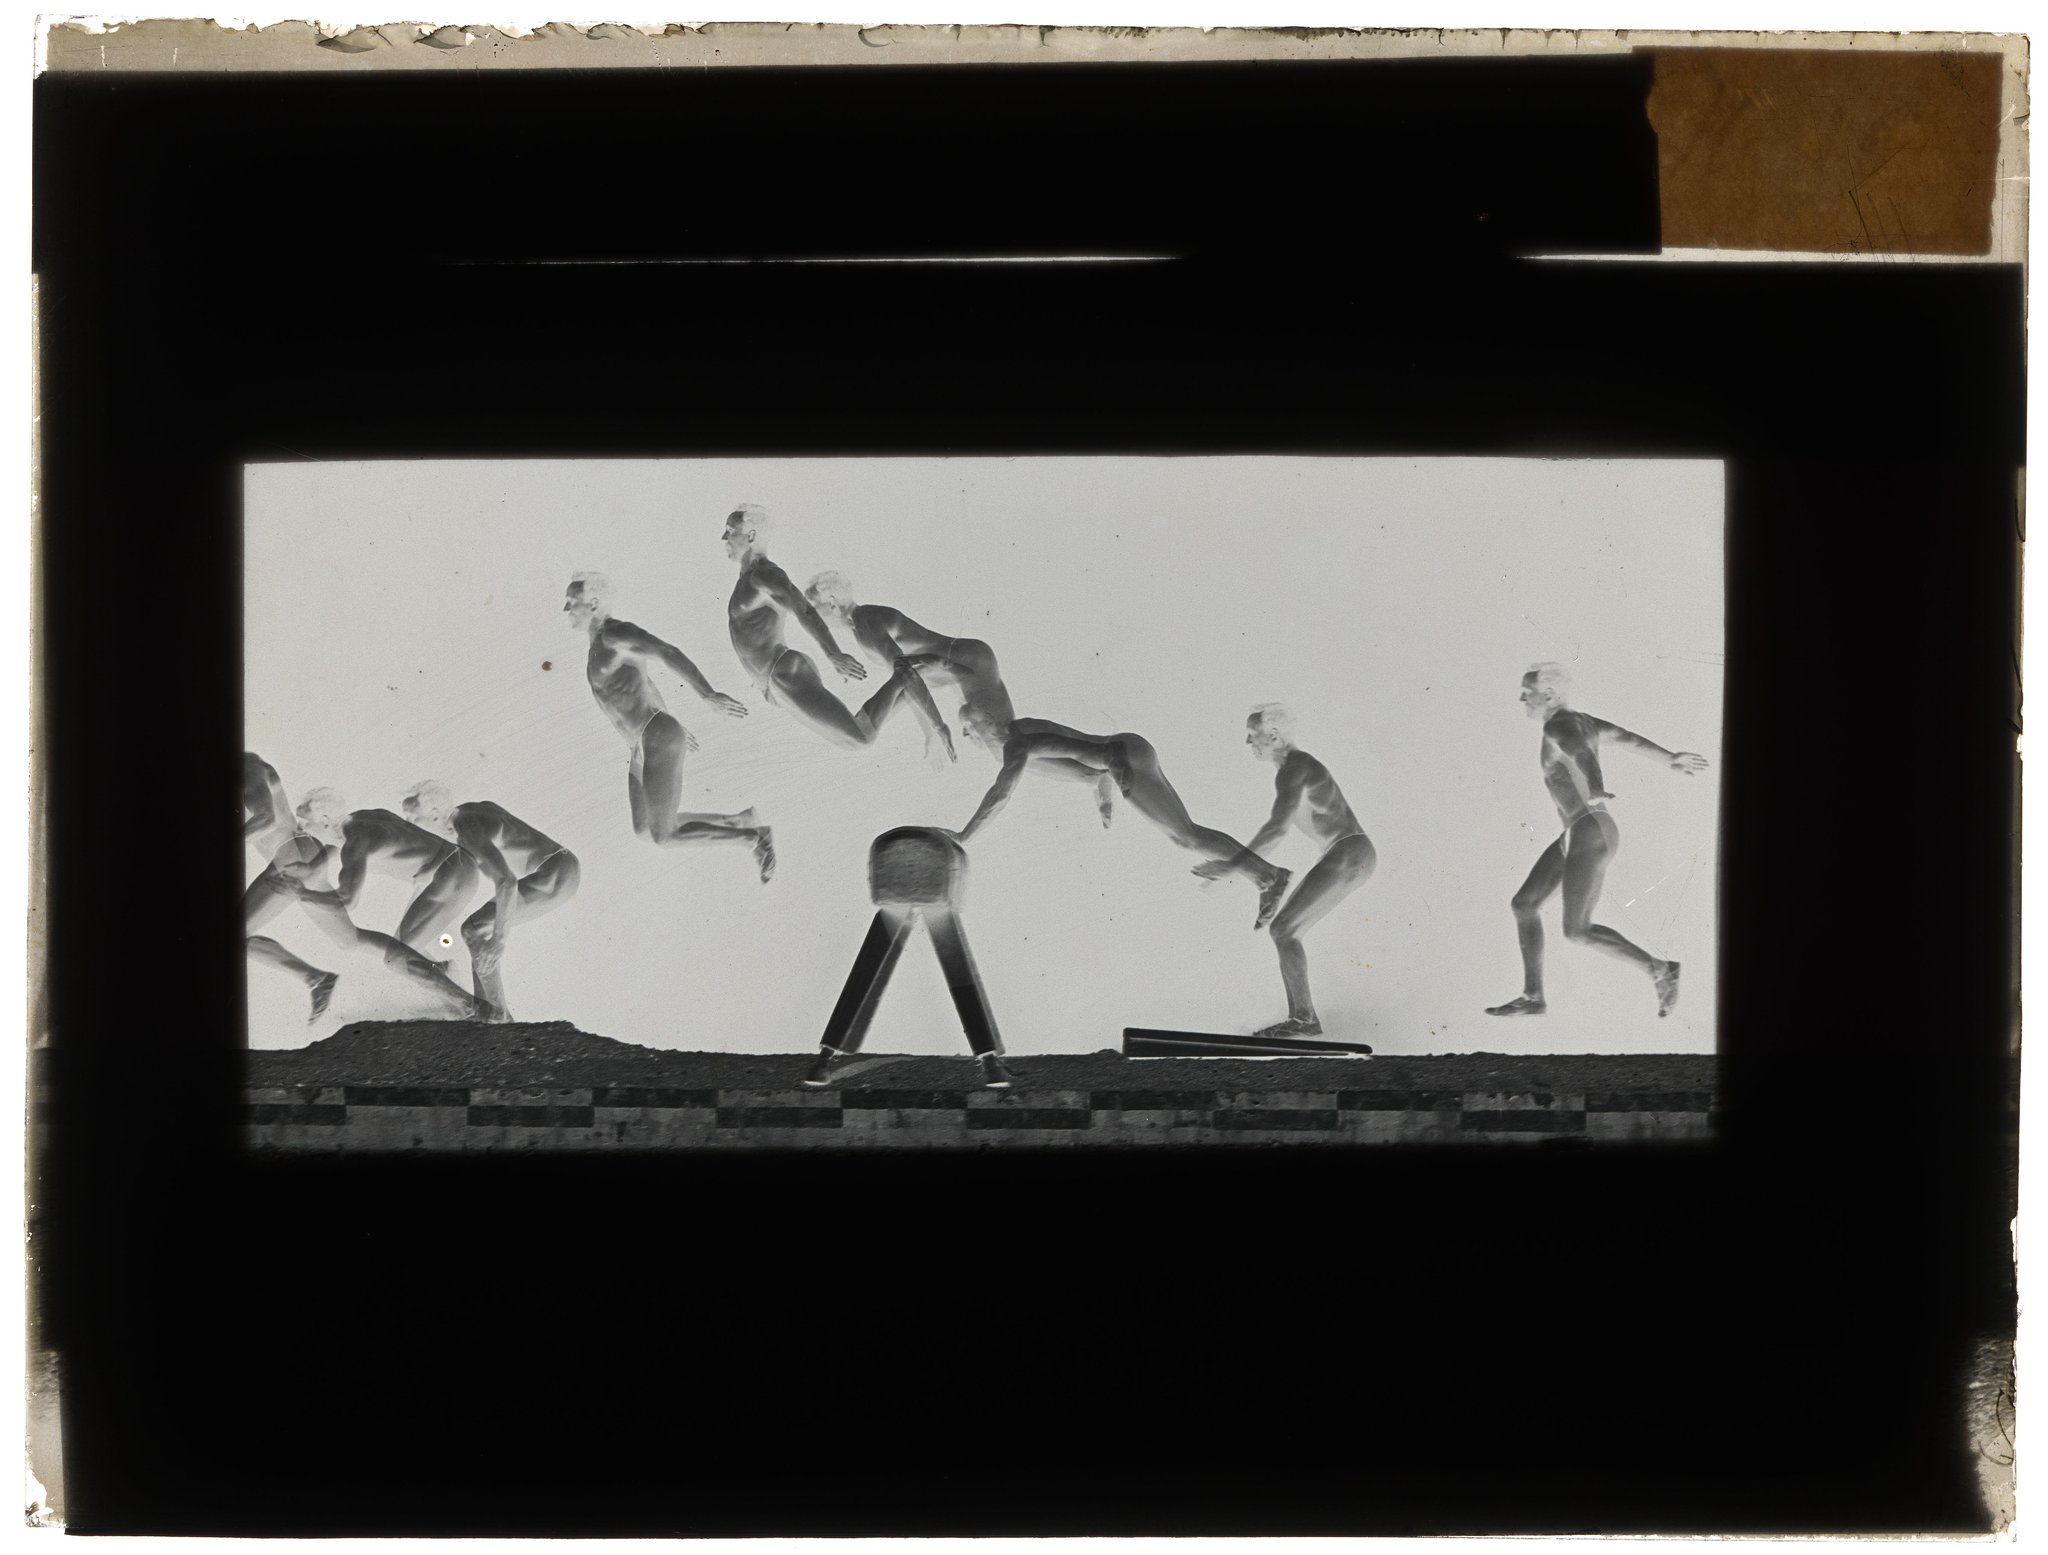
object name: glasnegatief, glasplaatnegatief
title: Man springt over de bok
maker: étienne-jules marey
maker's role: fotograaf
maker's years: 1830-1904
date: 1882-1890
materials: glass, paper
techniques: gelatin glass negative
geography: france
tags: adult man, automobile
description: Bij de negatieven zijn ook de duplicaatnegatieven en moderne afdrukken die voor de boekpublicatie vervaardigd zijn.